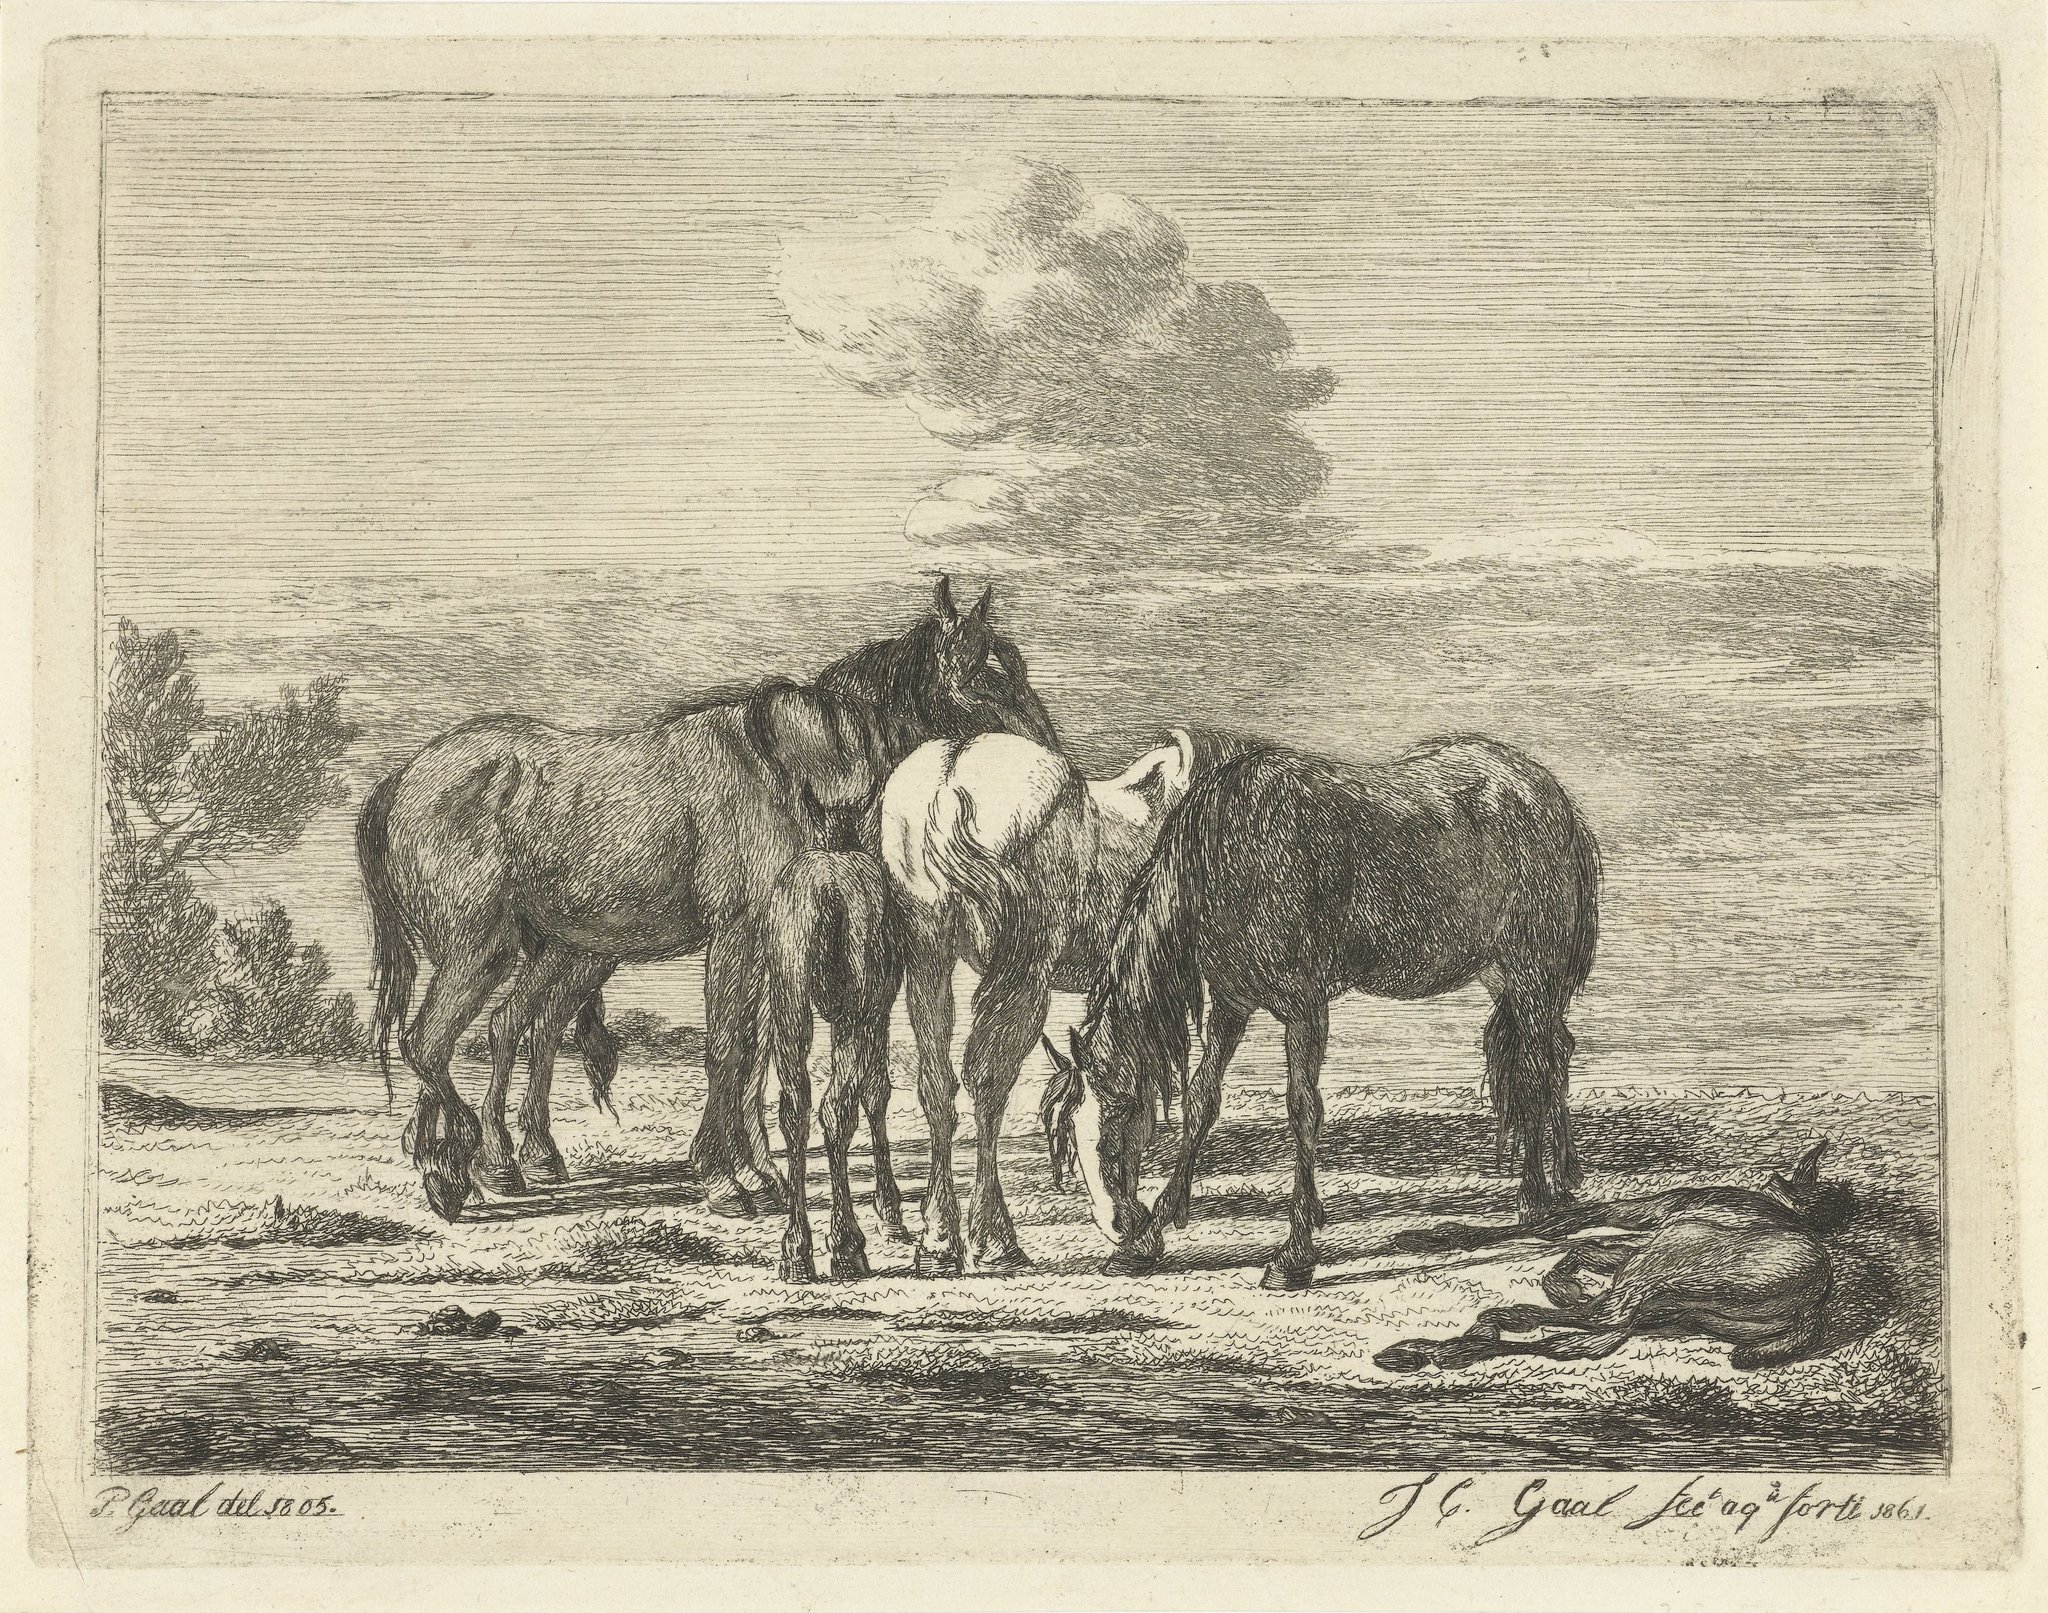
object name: print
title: Vier paarden en twee veulens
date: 1861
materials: paper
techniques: etching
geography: netherlands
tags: bull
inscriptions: collector's mark: Lugt 2228